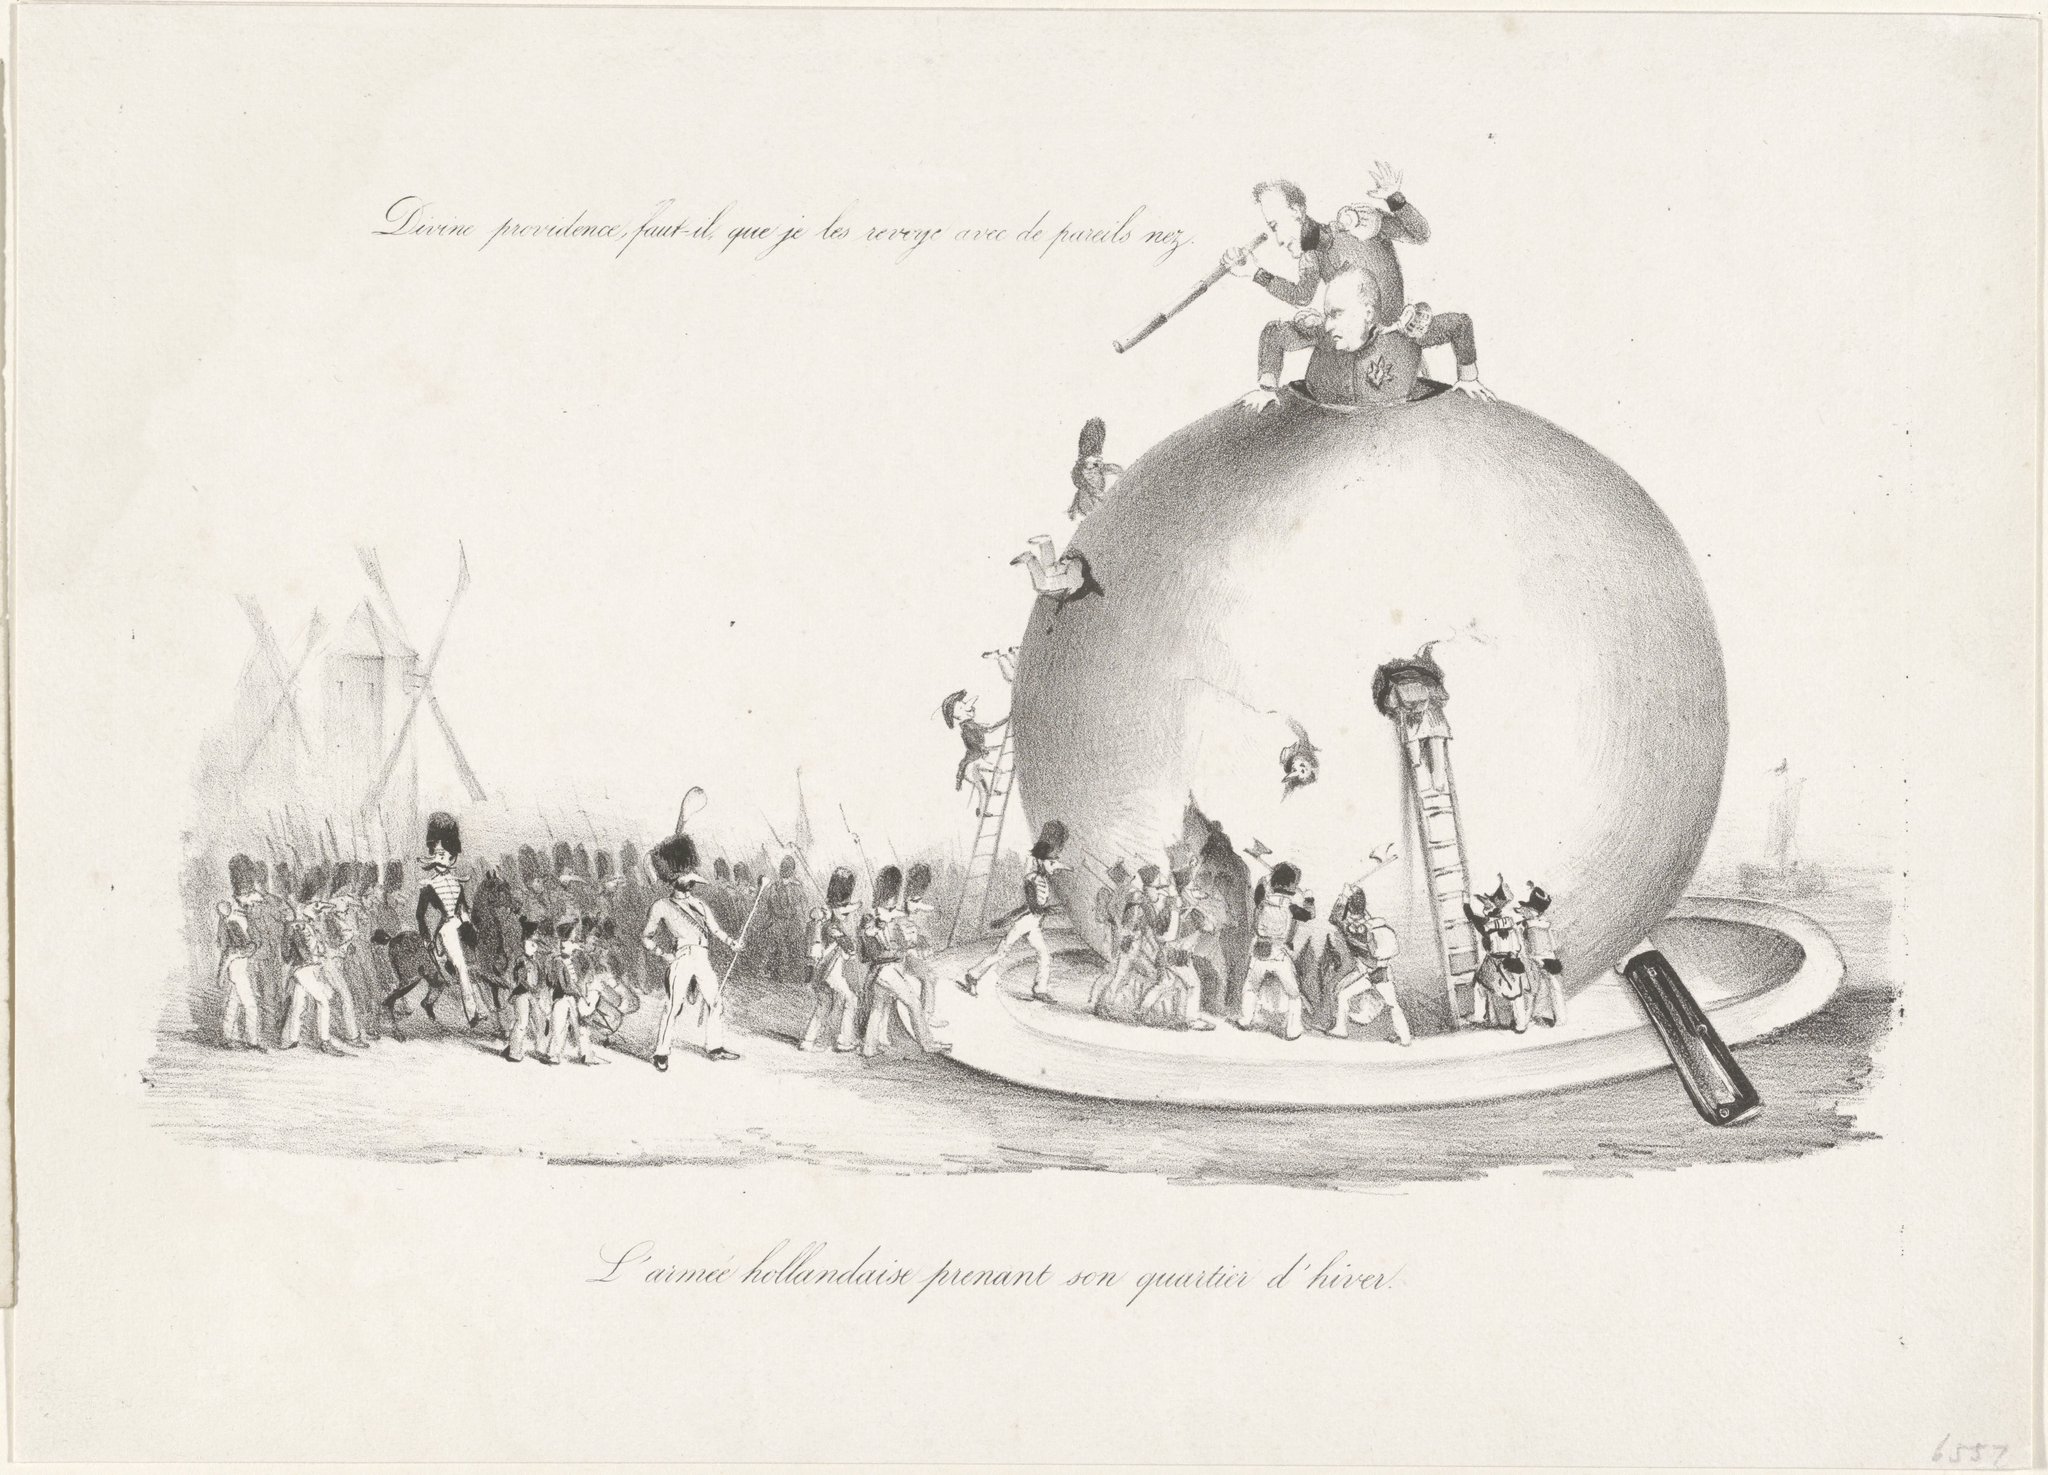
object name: print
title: Winterkwartier van de Hollandse troepen, 1830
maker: Anonymous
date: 1830-1831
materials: paper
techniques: lithograph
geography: belgium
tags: the hague, berlin, william i of the netherlands, frederik (prins der nederlanden), shelter ~ military service, cheese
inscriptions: collector's mark: Lugt 2228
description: Spotprent op de terugtrekking van de Nederlandse troepen uit België, november 1830. Nederlandse troepen nemen winterkwartier in een grote ronde kaas dat op een bord ligt met een mes erbij. In de kaas bevinden zich koning Willem I en prins Frederik. De soldaten hebben lange neuzen en sommigen hakken zich een weg naar binnen of klimmen met een ladder in de kaas.